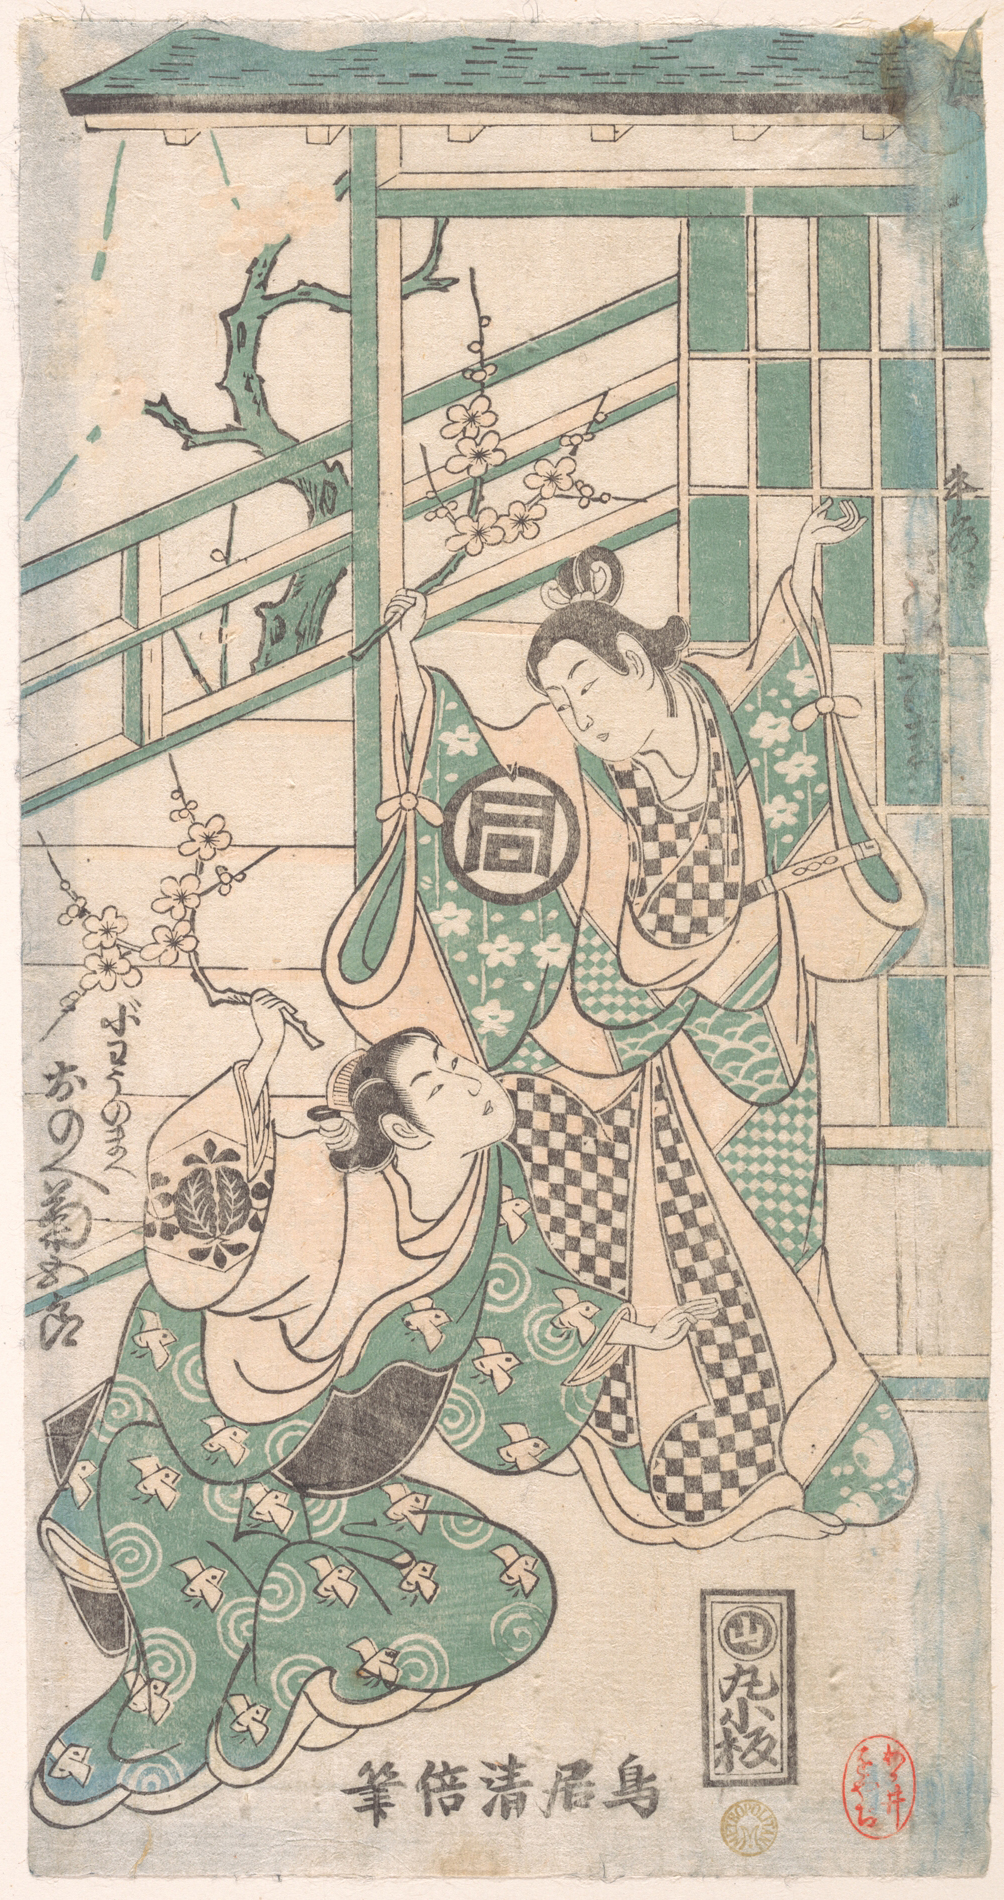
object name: woodblock print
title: Scene From the Drama "Hatsu-tori Kuruma Genji"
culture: japanese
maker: torii kiyomasu i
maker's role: artist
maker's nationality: japanese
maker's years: 1696-1716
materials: ink, paper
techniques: woodblock print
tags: human figures,flowers,actors